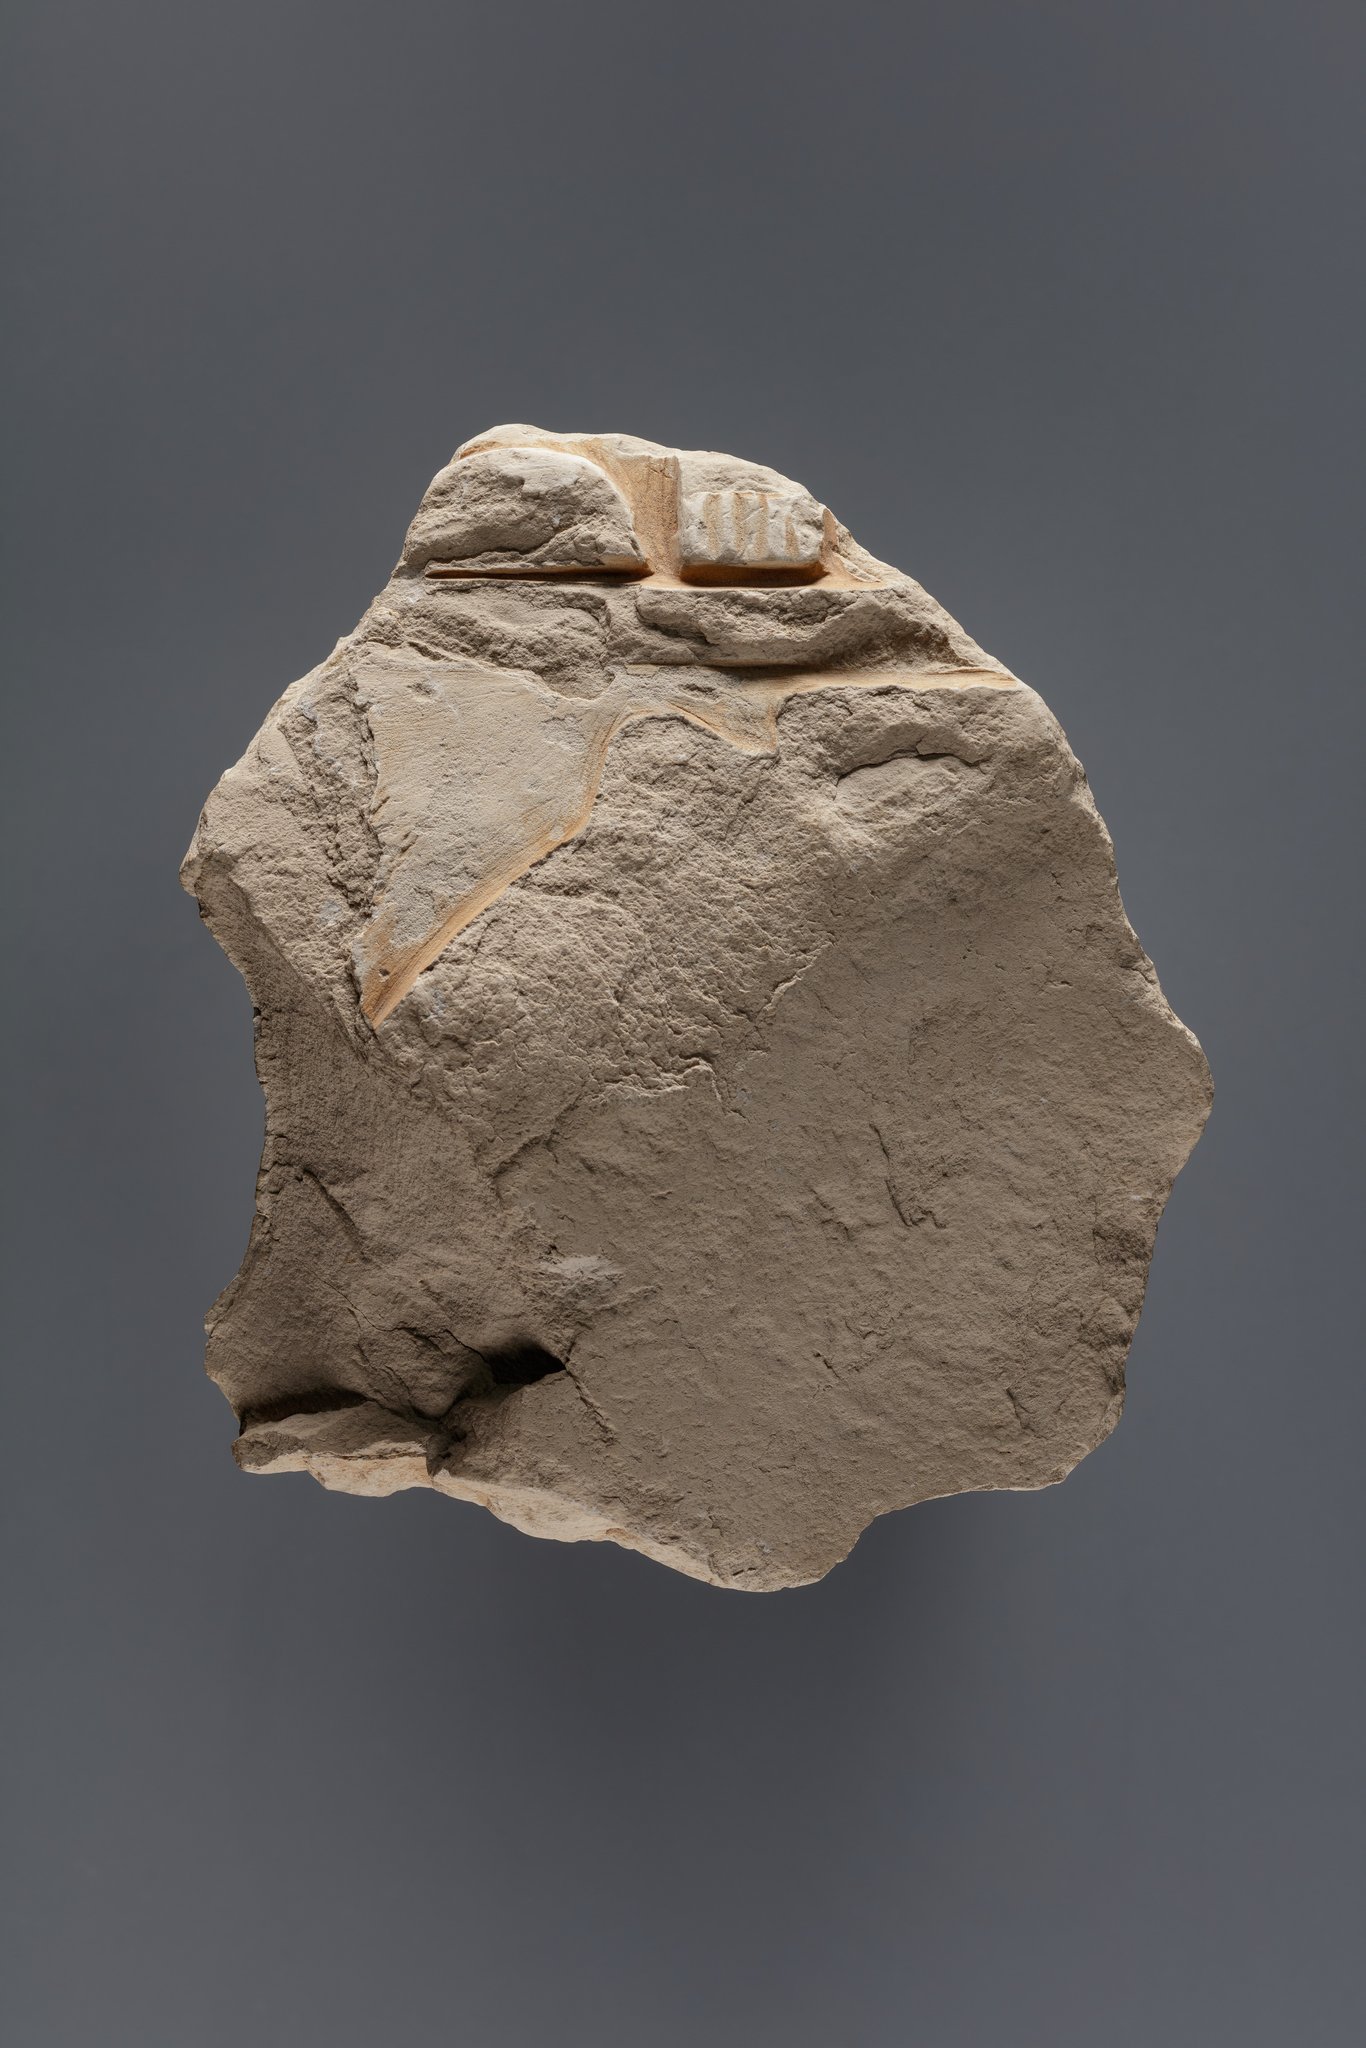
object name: relief fragment 47, tomb of mereri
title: Relief fragment possibly from the tomb of Mereri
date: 2100-2090 BCE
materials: stone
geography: egypt